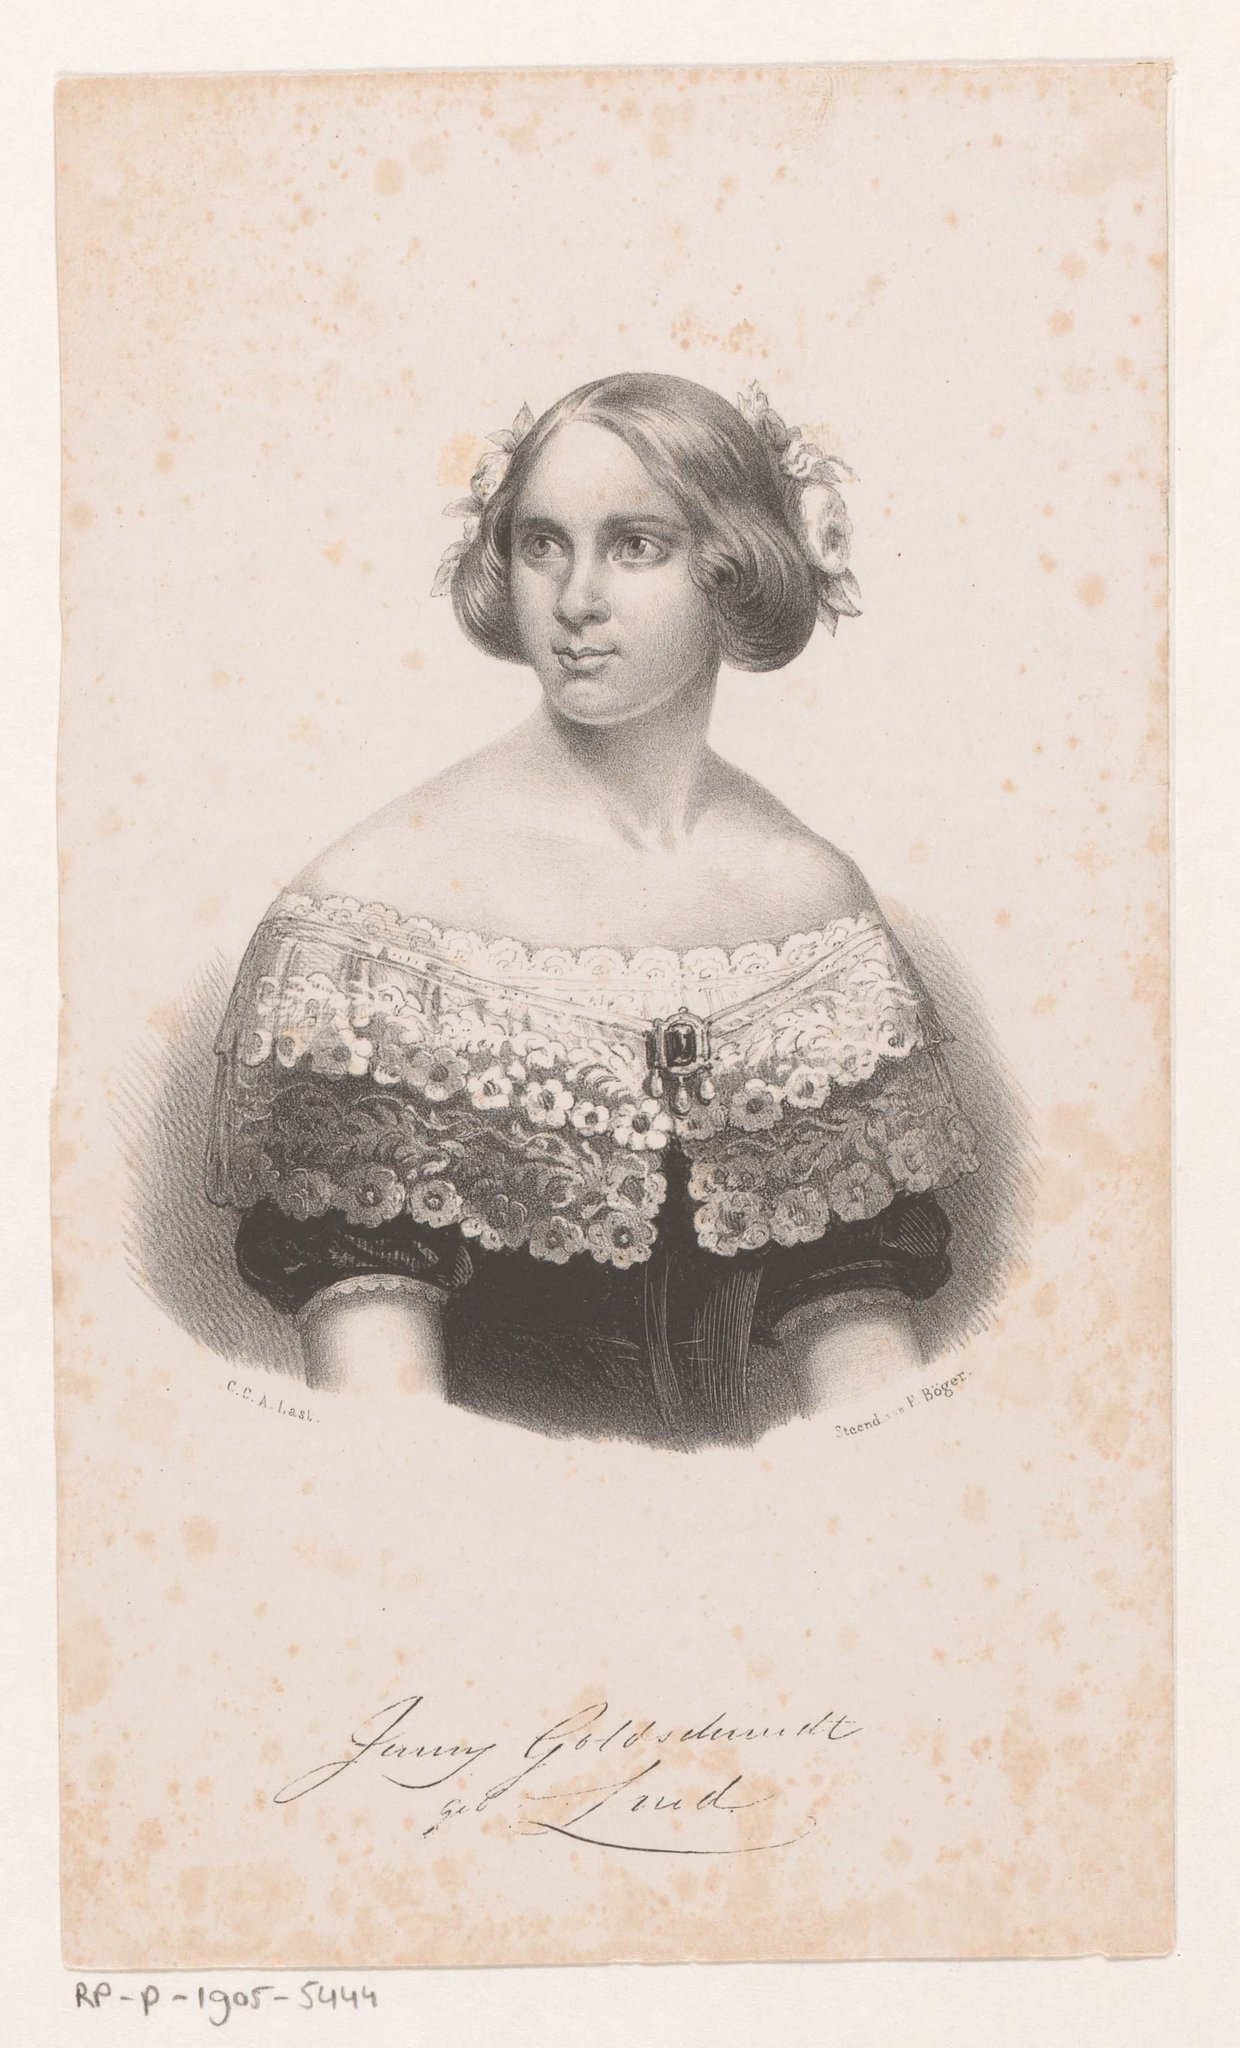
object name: print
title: Portret van Jenny Lind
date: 1846-1876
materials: paper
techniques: lithograph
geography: dordrecht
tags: historical persons - bb - woman (+ (full) bust portrait)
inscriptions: collector's mark: Lugt 2228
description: De geportretteerde draagt een jurk met ontblote schouders en bloemen in het haar. Onder het portret haar signatuur.